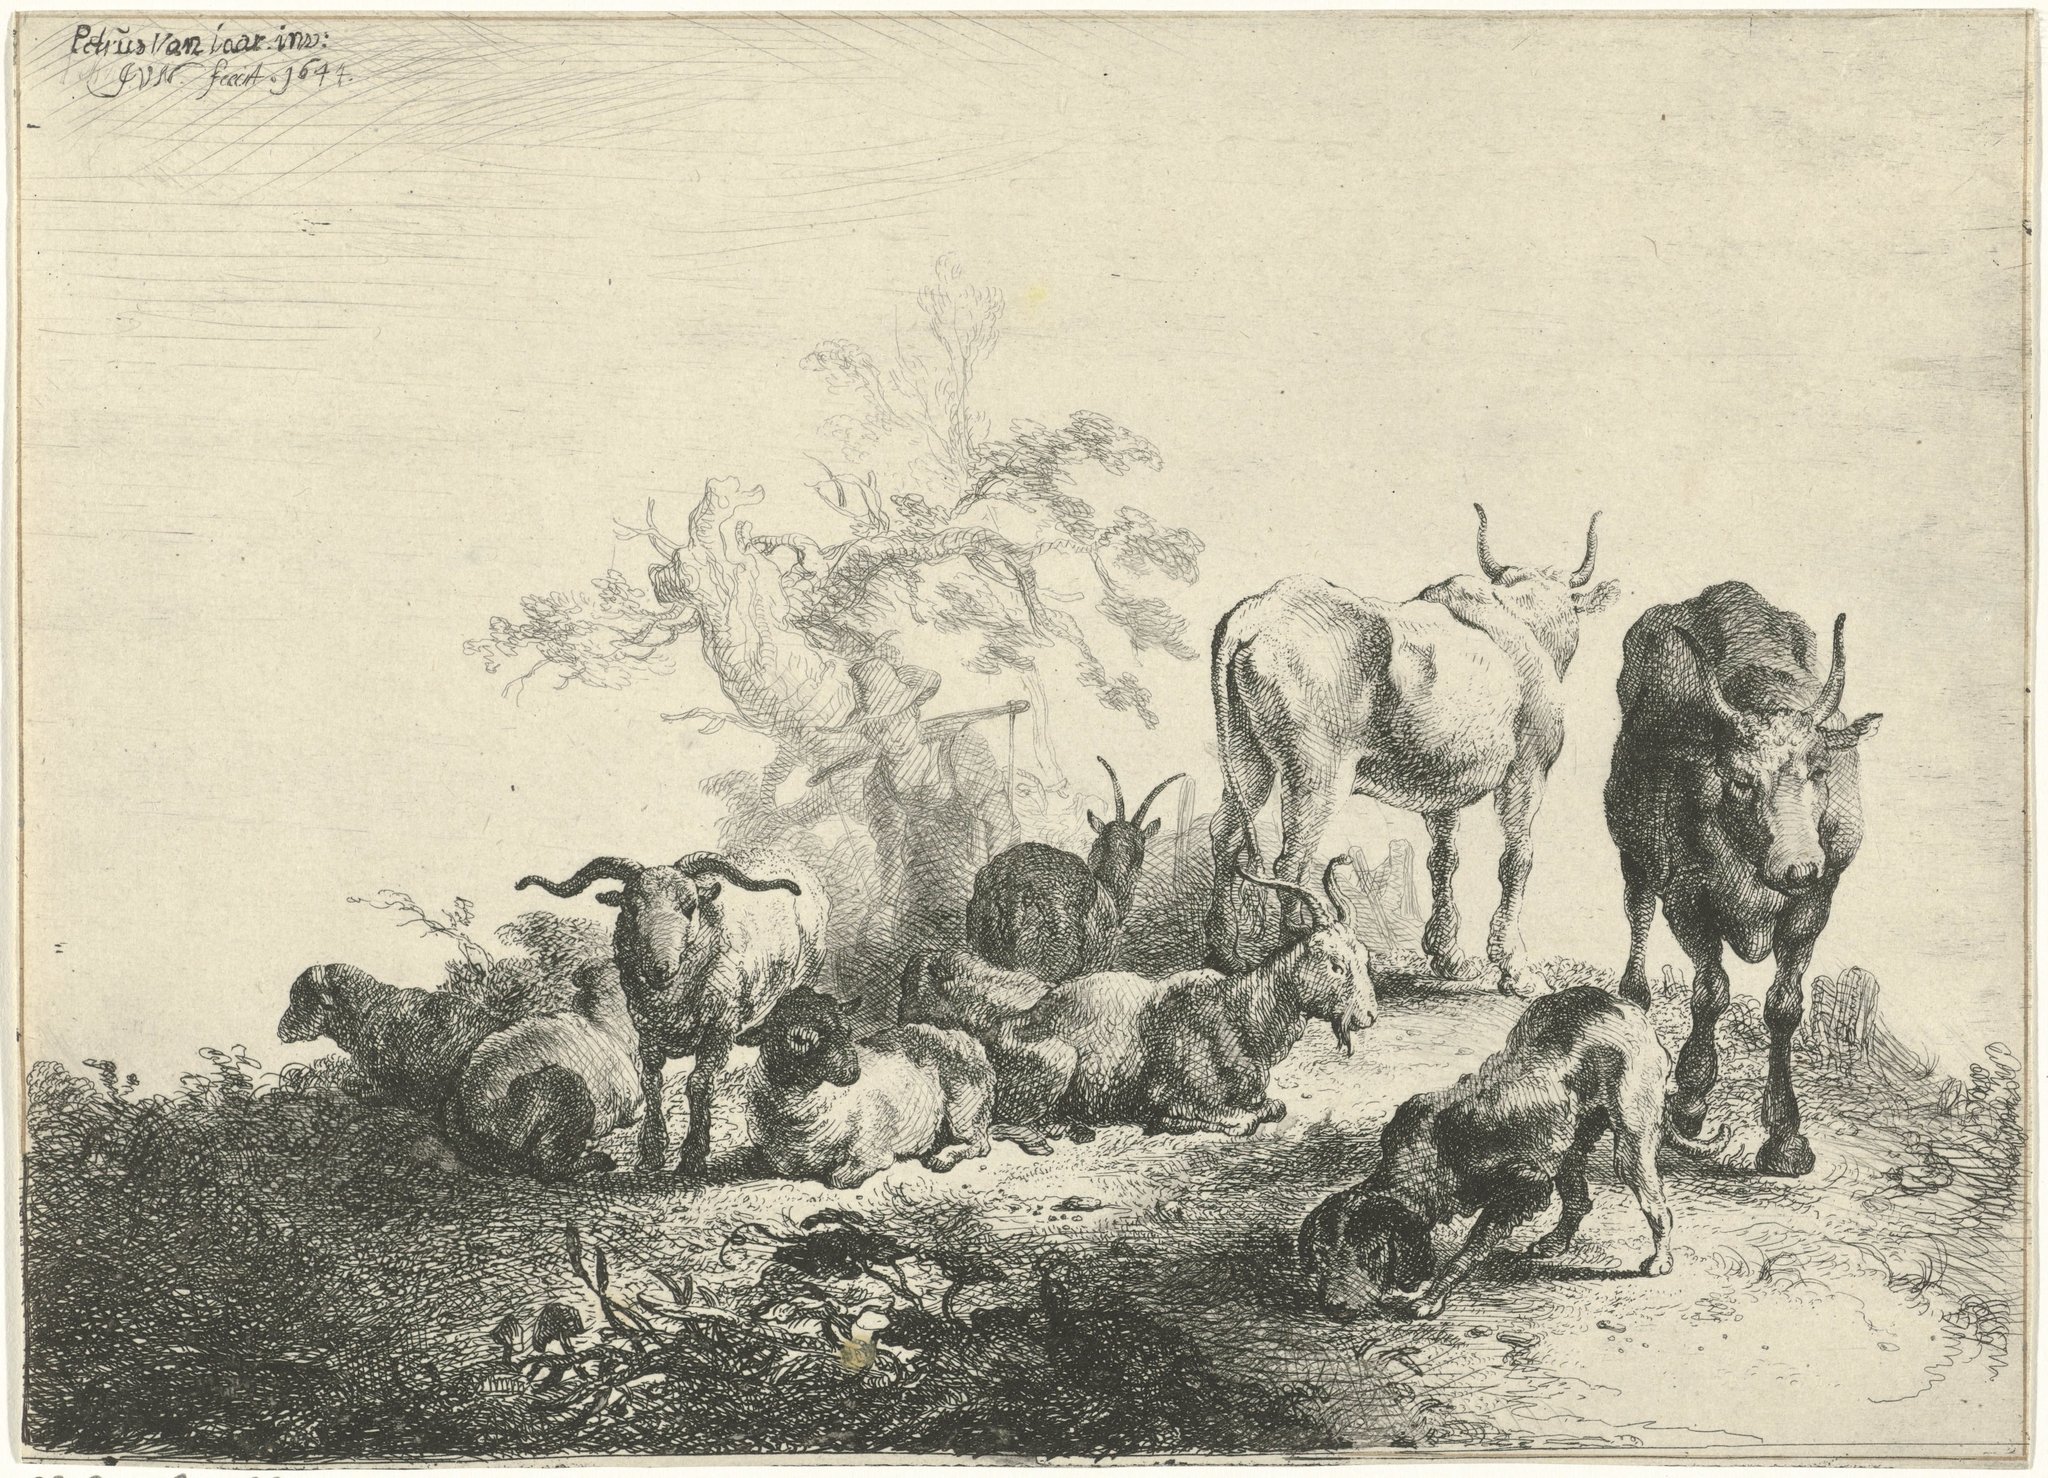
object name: print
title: Landschap met vee en een melkmeid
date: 1644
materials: paper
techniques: engraving, etching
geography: amsterdam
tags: cow, goat, milkmaid, dog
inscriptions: collector's mark: Lugt 2610, collector's mark: Lugt 2228, collector's mark: Lugt 2925a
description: In een landschap staan enkele koeien, geiten en een hond. Daarachter staat een melkmeid met een juk op haar schouders.